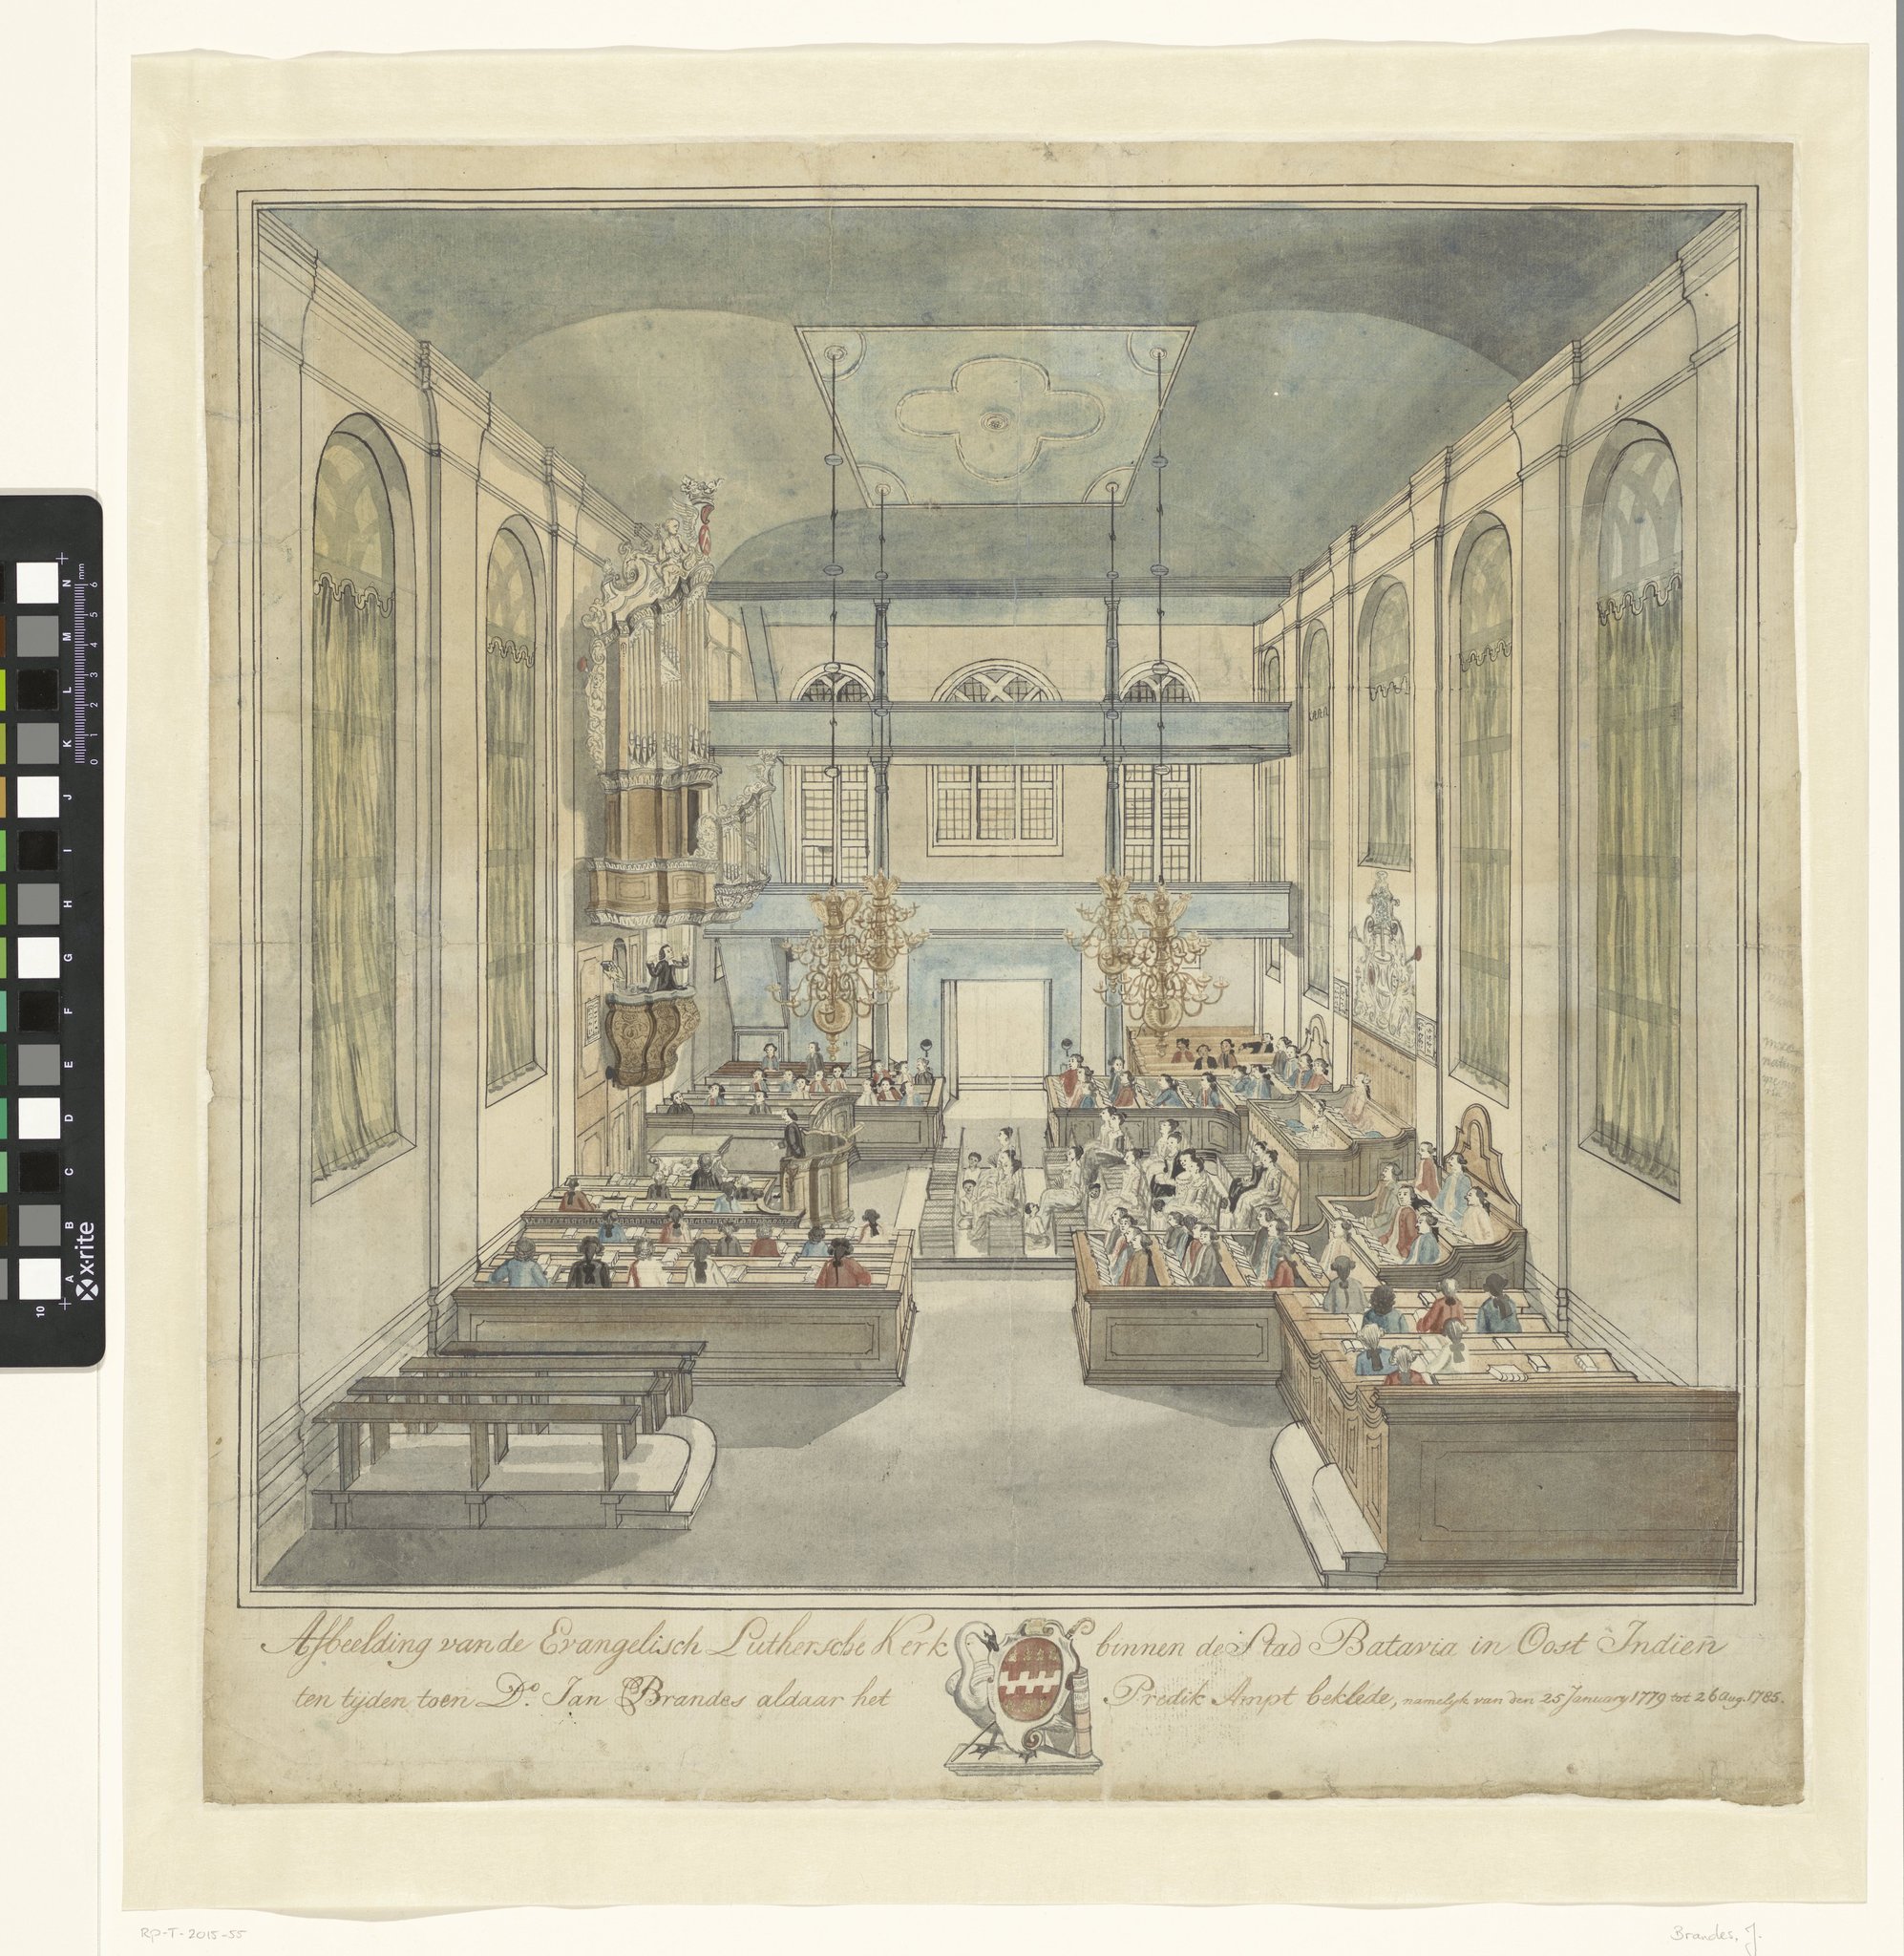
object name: drawing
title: Evangelisch Lutersche Kerk binnen de stad Batavia in Oost-Indië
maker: jan brandes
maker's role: draughtsman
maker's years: 1743-1808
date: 1785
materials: paper, watercolor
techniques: brush, pen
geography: batavia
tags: interior of church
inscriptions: caption: ‘Afbeelding van de Evangelisch Lutersche Kerk binnen de stad Batavia in Oost Indiën ten tijden toen Do. Jan Brandes aldaar het Predik Ampt beklede namelijk van den 25 Januarij 1779 tot 26 Aug. 1785.’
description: Interieur van de Lutherse Kerk in Batavia met Jan Brandes op de kansel.